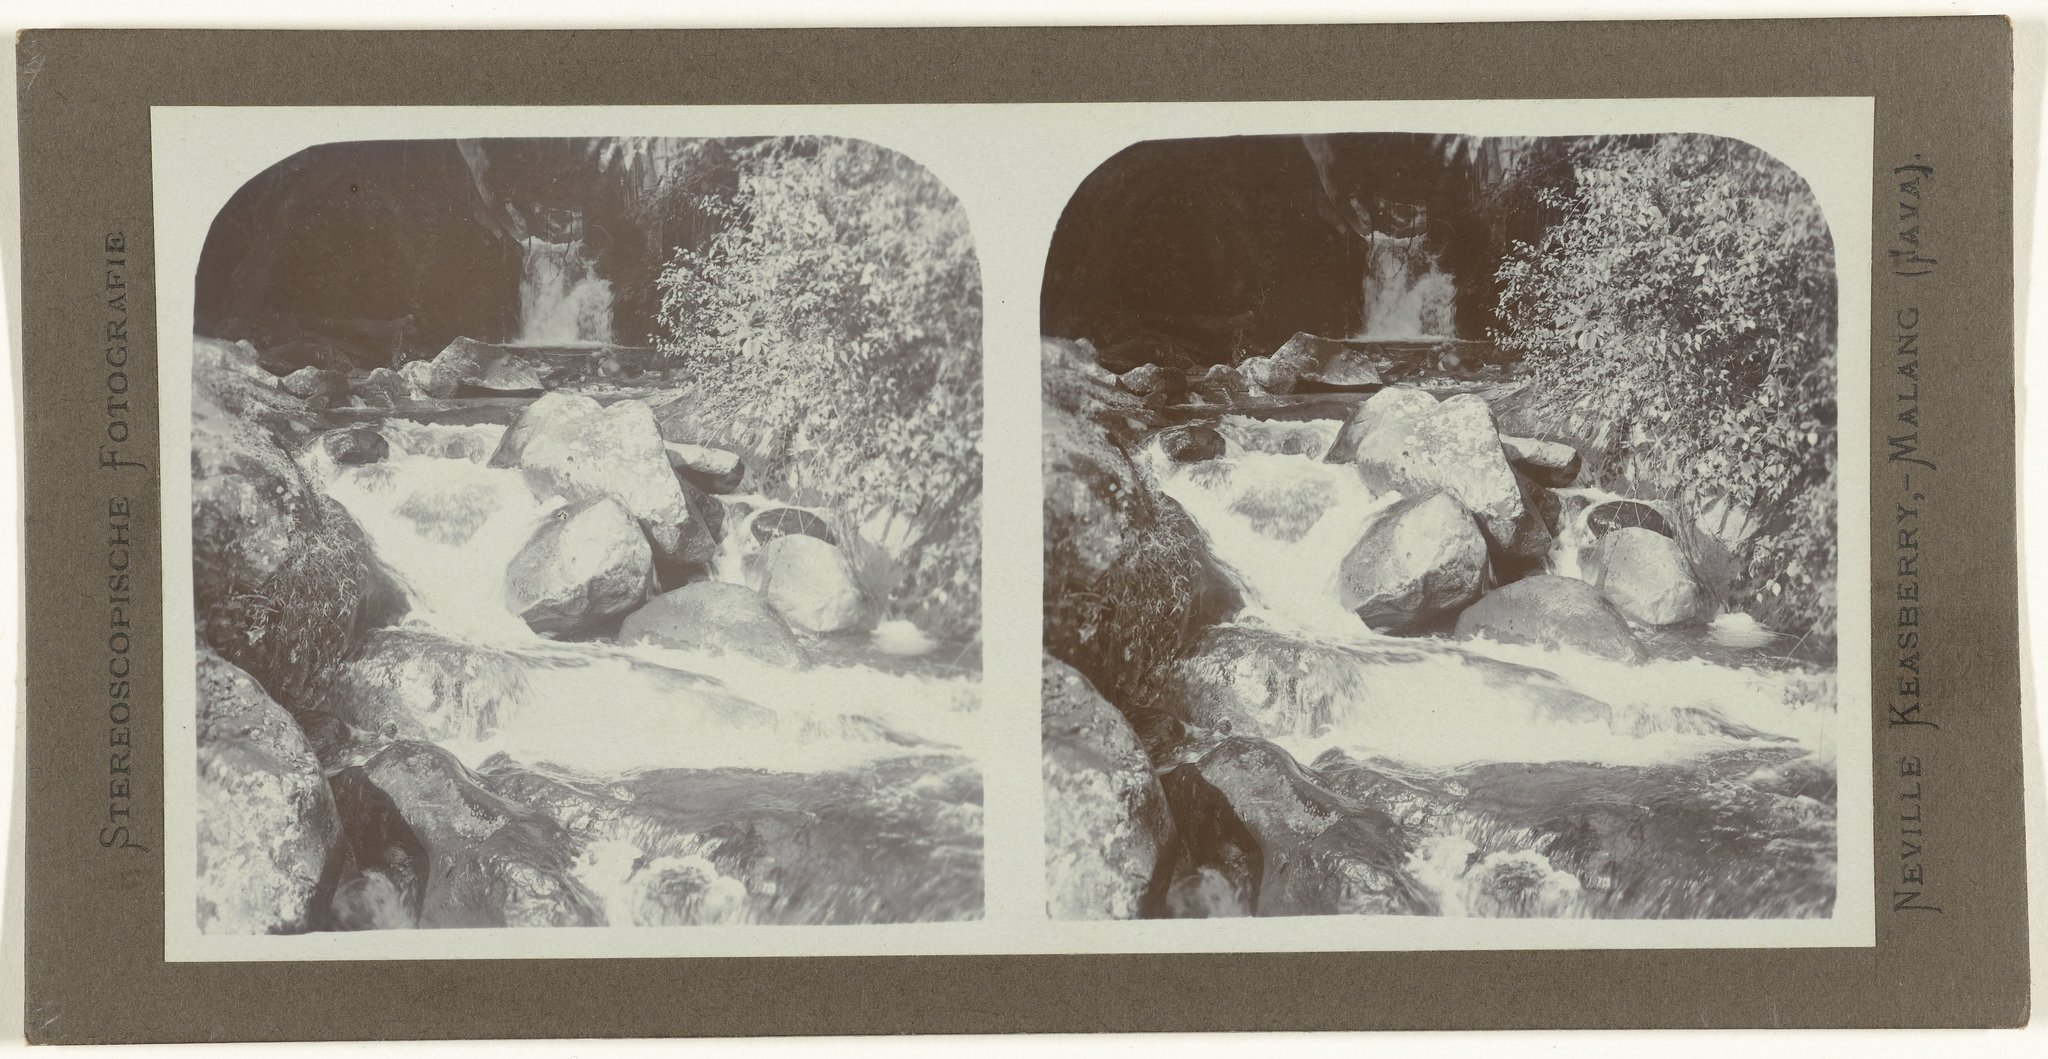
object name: stereograph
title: S 8 No 95. Het nymphen-bad in Prigen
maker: neville keasberry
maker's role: fotograaf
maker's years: 1866-1944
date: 1900-1935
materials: cardboard, paper, photographic support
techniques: albumen print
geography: malang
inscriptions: signature: ‘Neville Keasberry, Malang (Java)’, inscription: ‘Stereoscopische Fotografie’